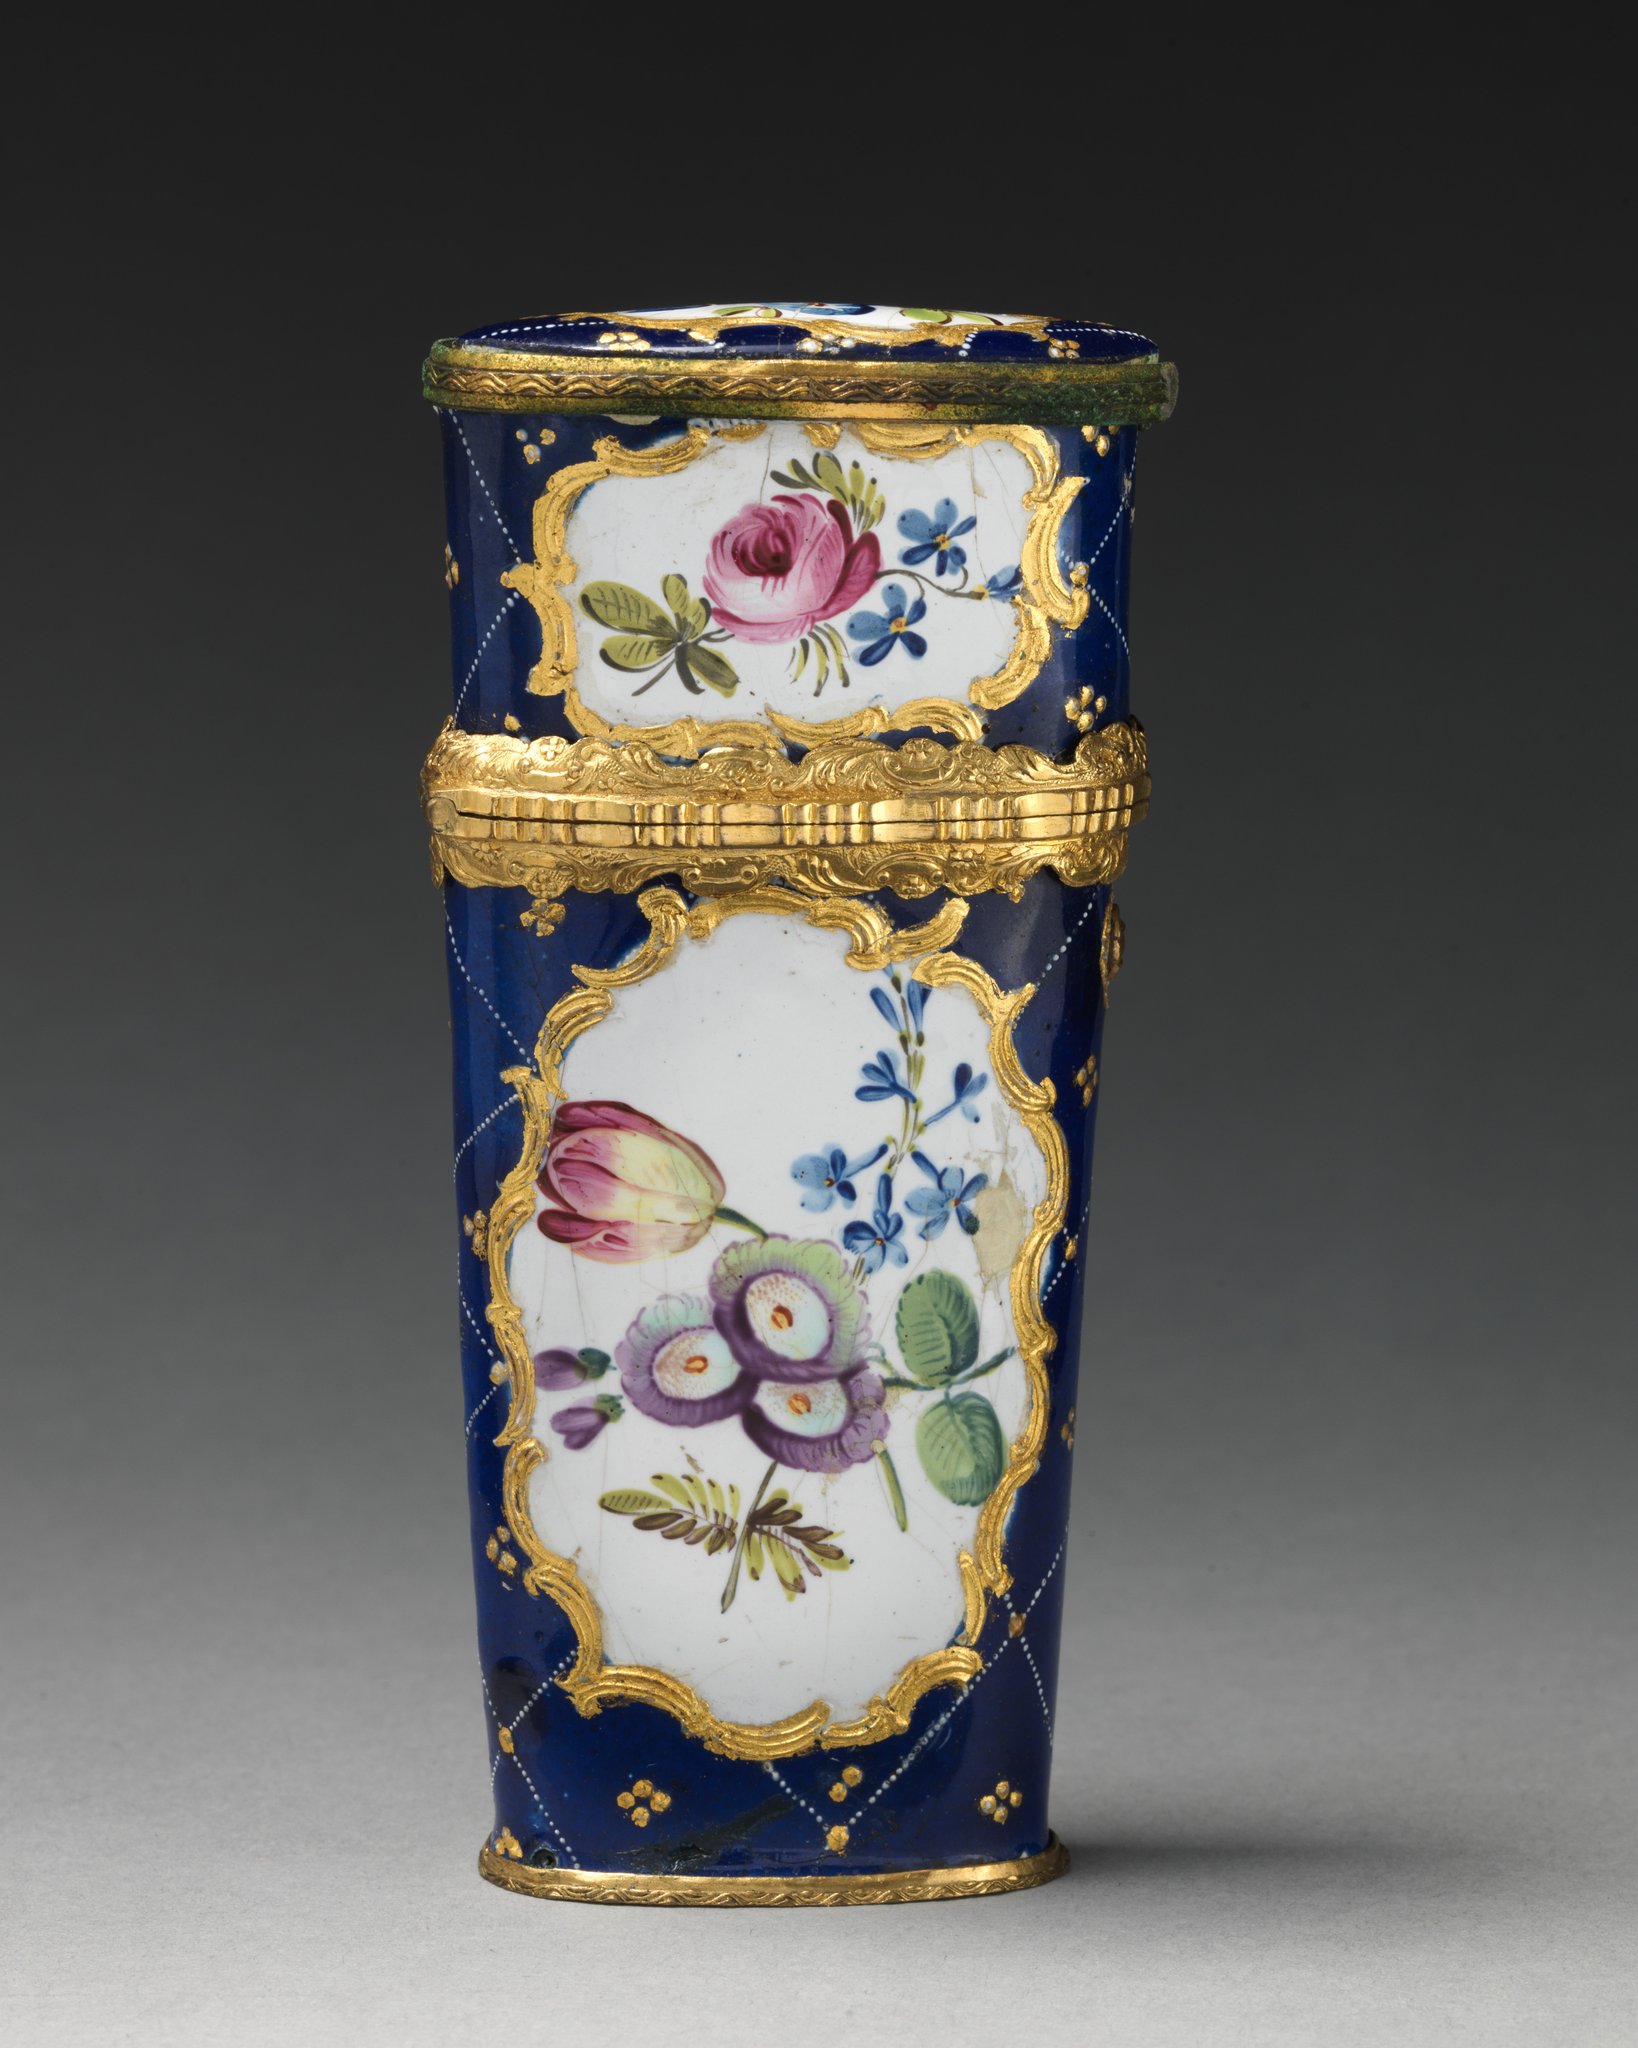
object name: étui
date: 1765-1770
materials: copper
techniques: enamel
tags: flowers